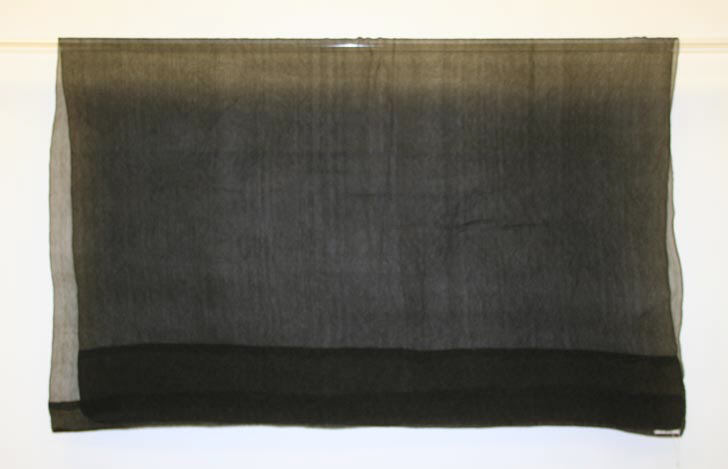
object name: mourning veil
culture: american or european